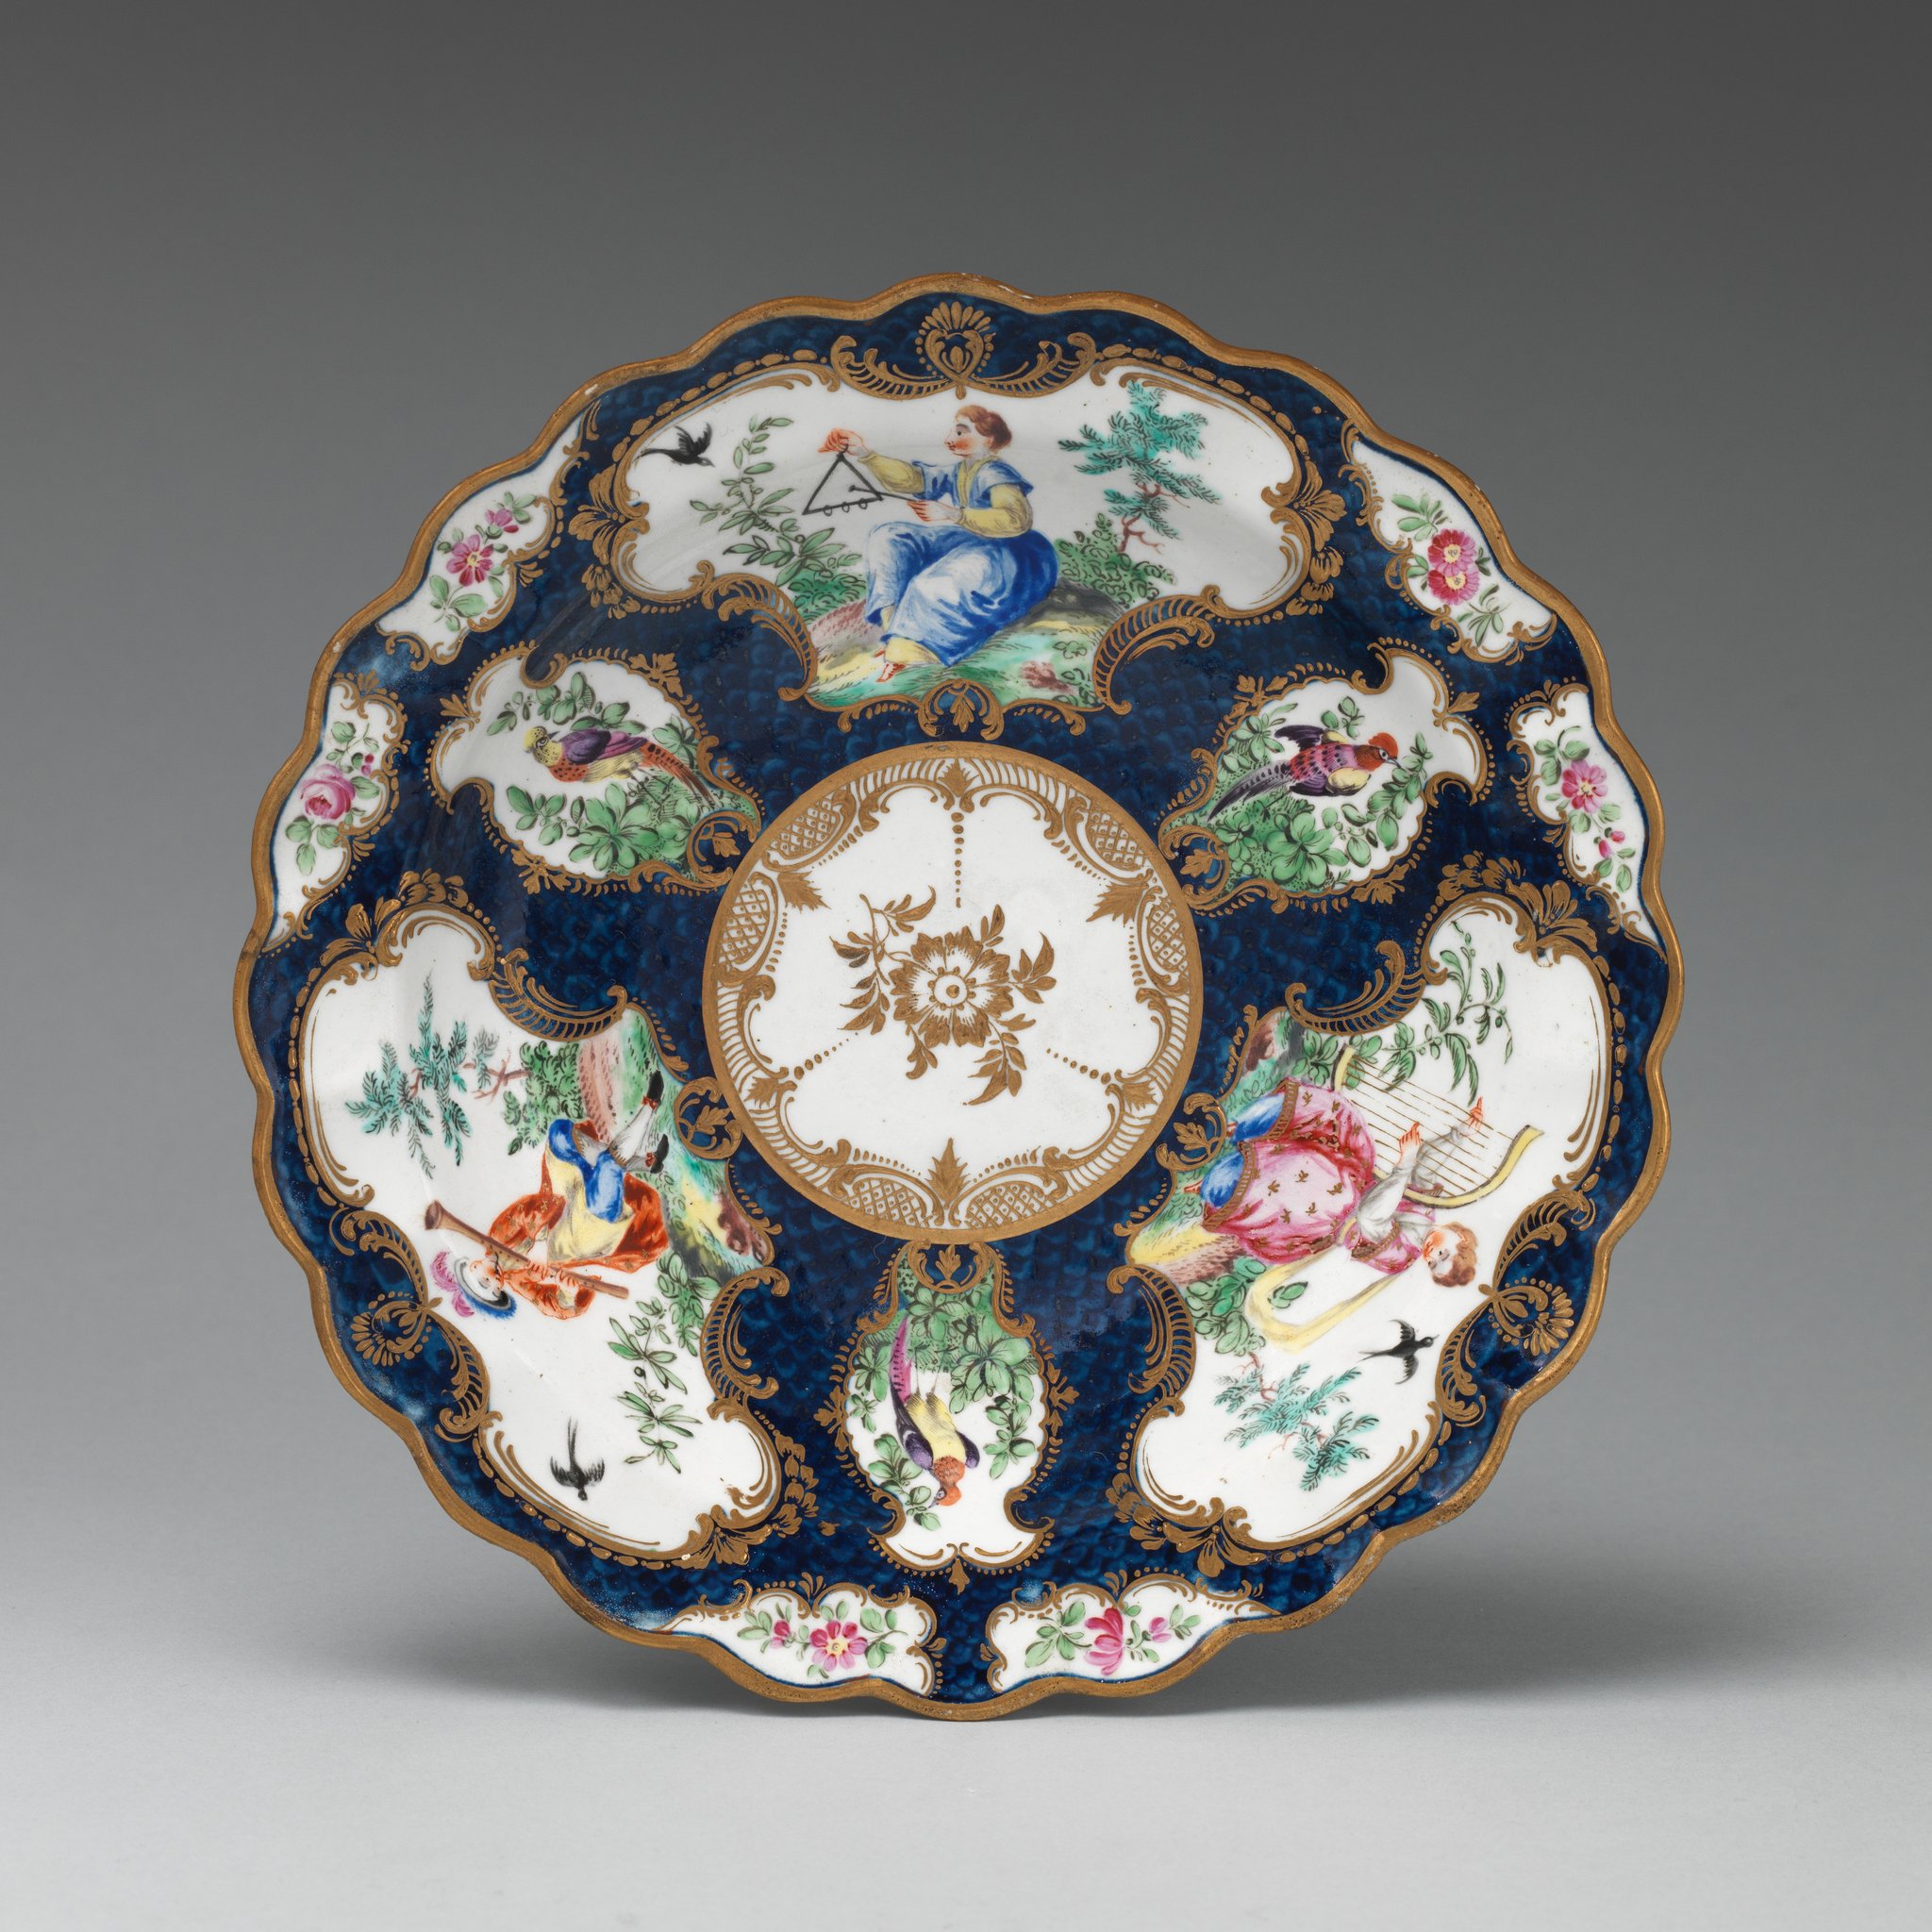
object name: dish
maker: worcester factory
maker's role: factory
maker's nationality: british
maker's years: 1751-2008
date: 1770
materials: soft paste porcelain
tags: birds,harps,trees,musicians